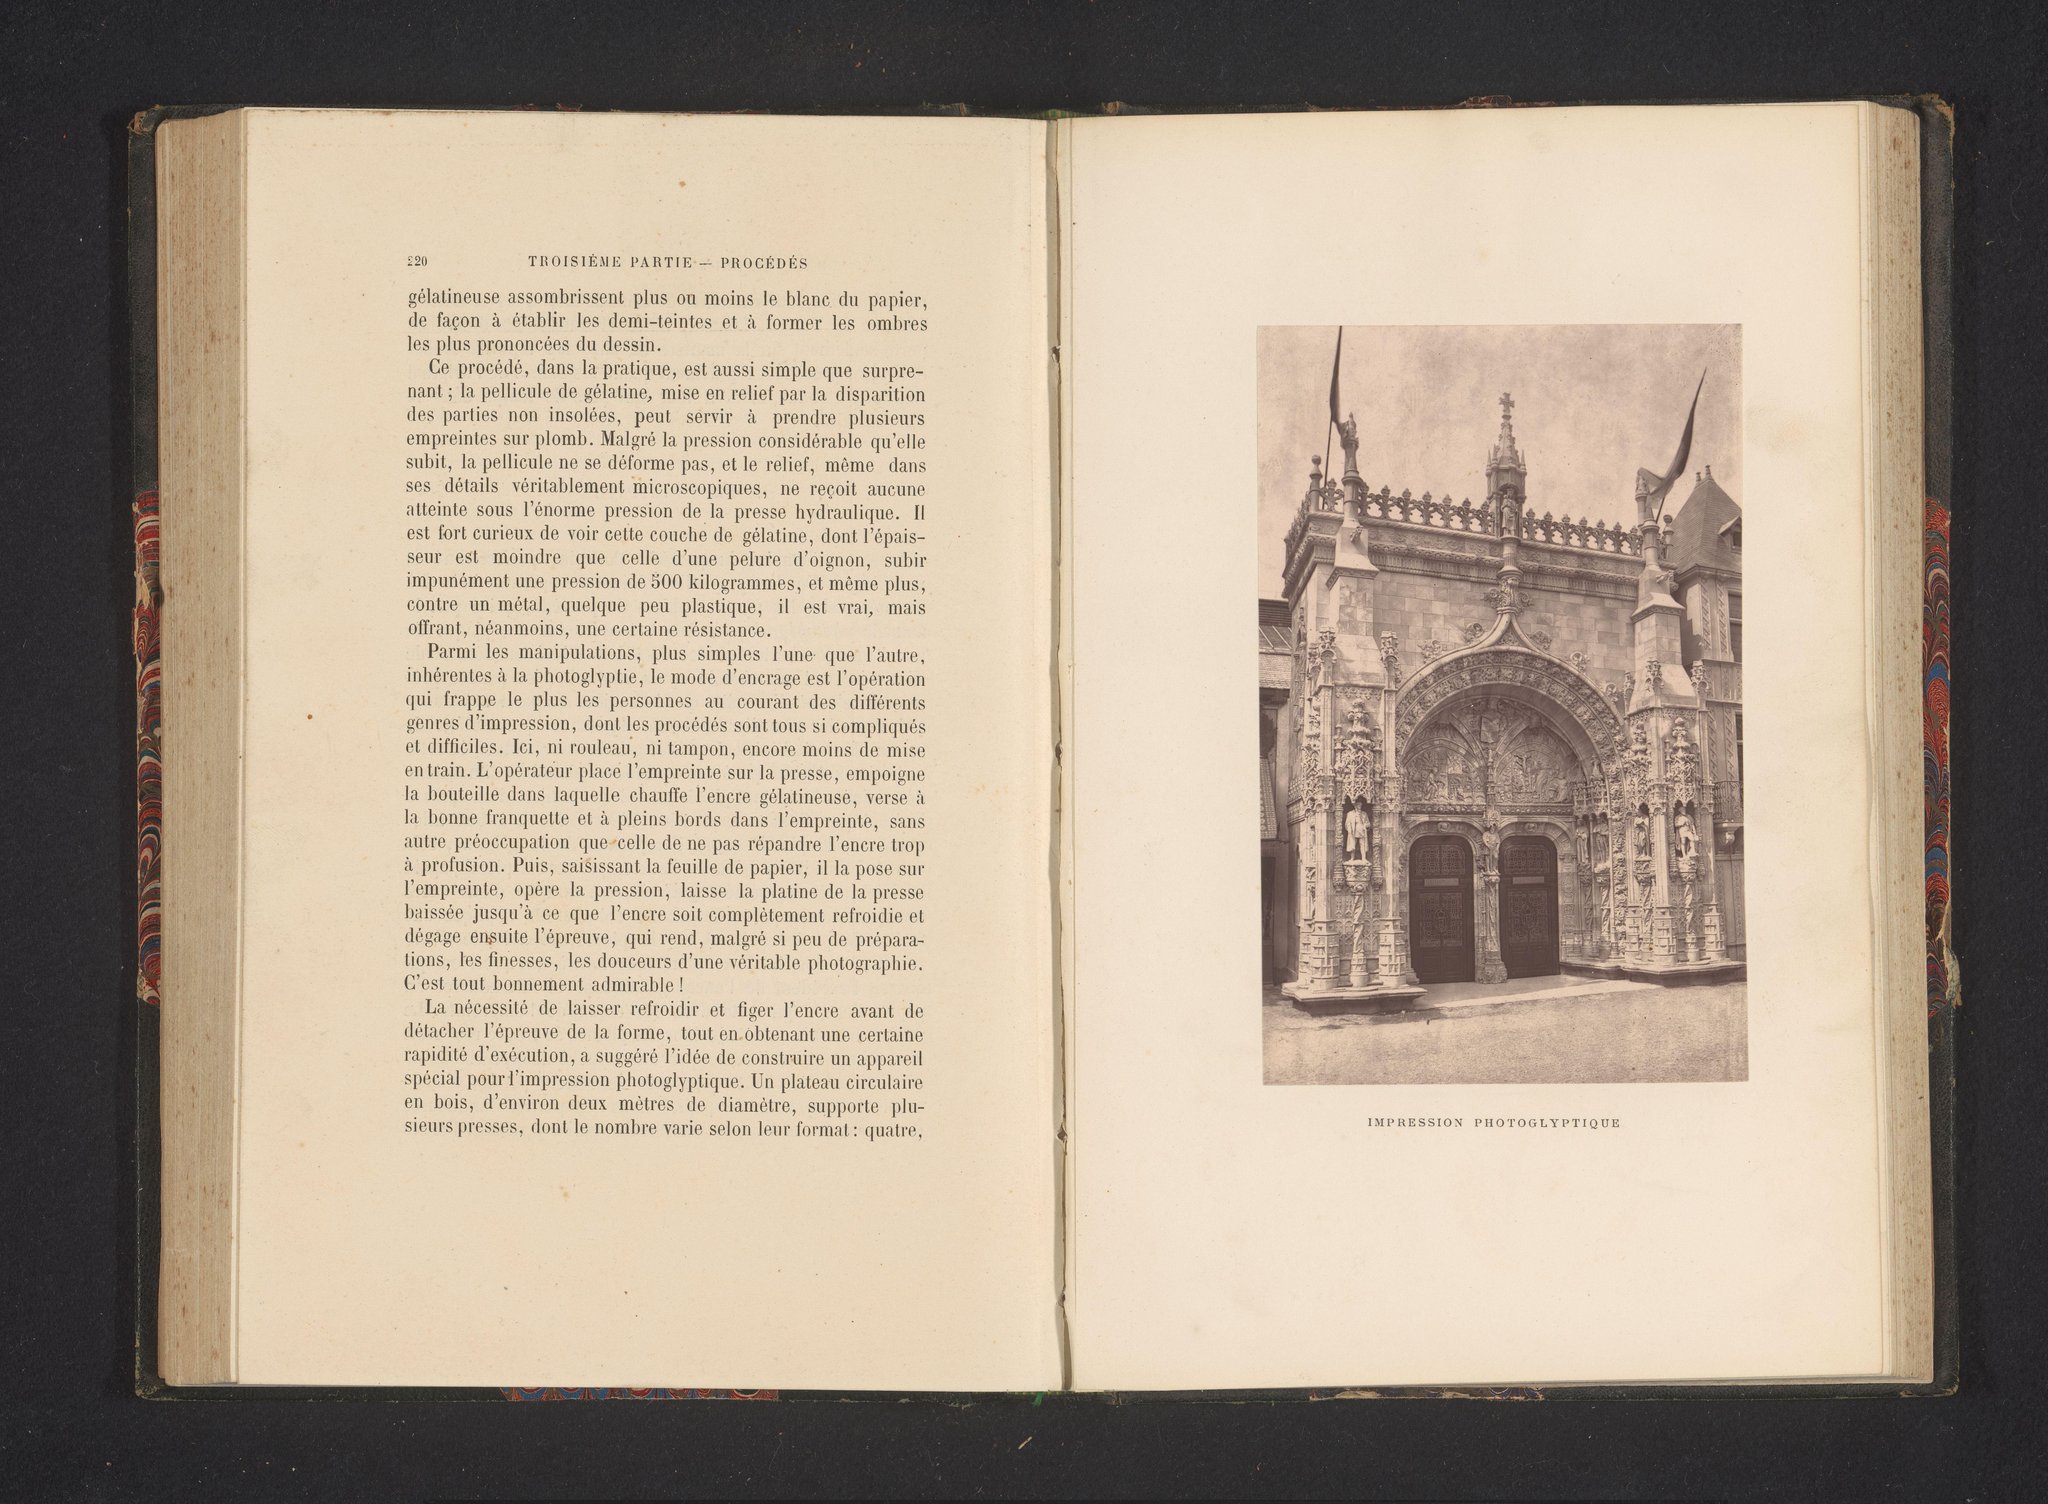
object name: photomechanical print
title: Gezicht op een timpaan over twee deuren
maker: Anonymous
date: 1883-1888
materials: paper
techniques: woodburytype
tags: parts of church exterior and annexes: tympanum, door